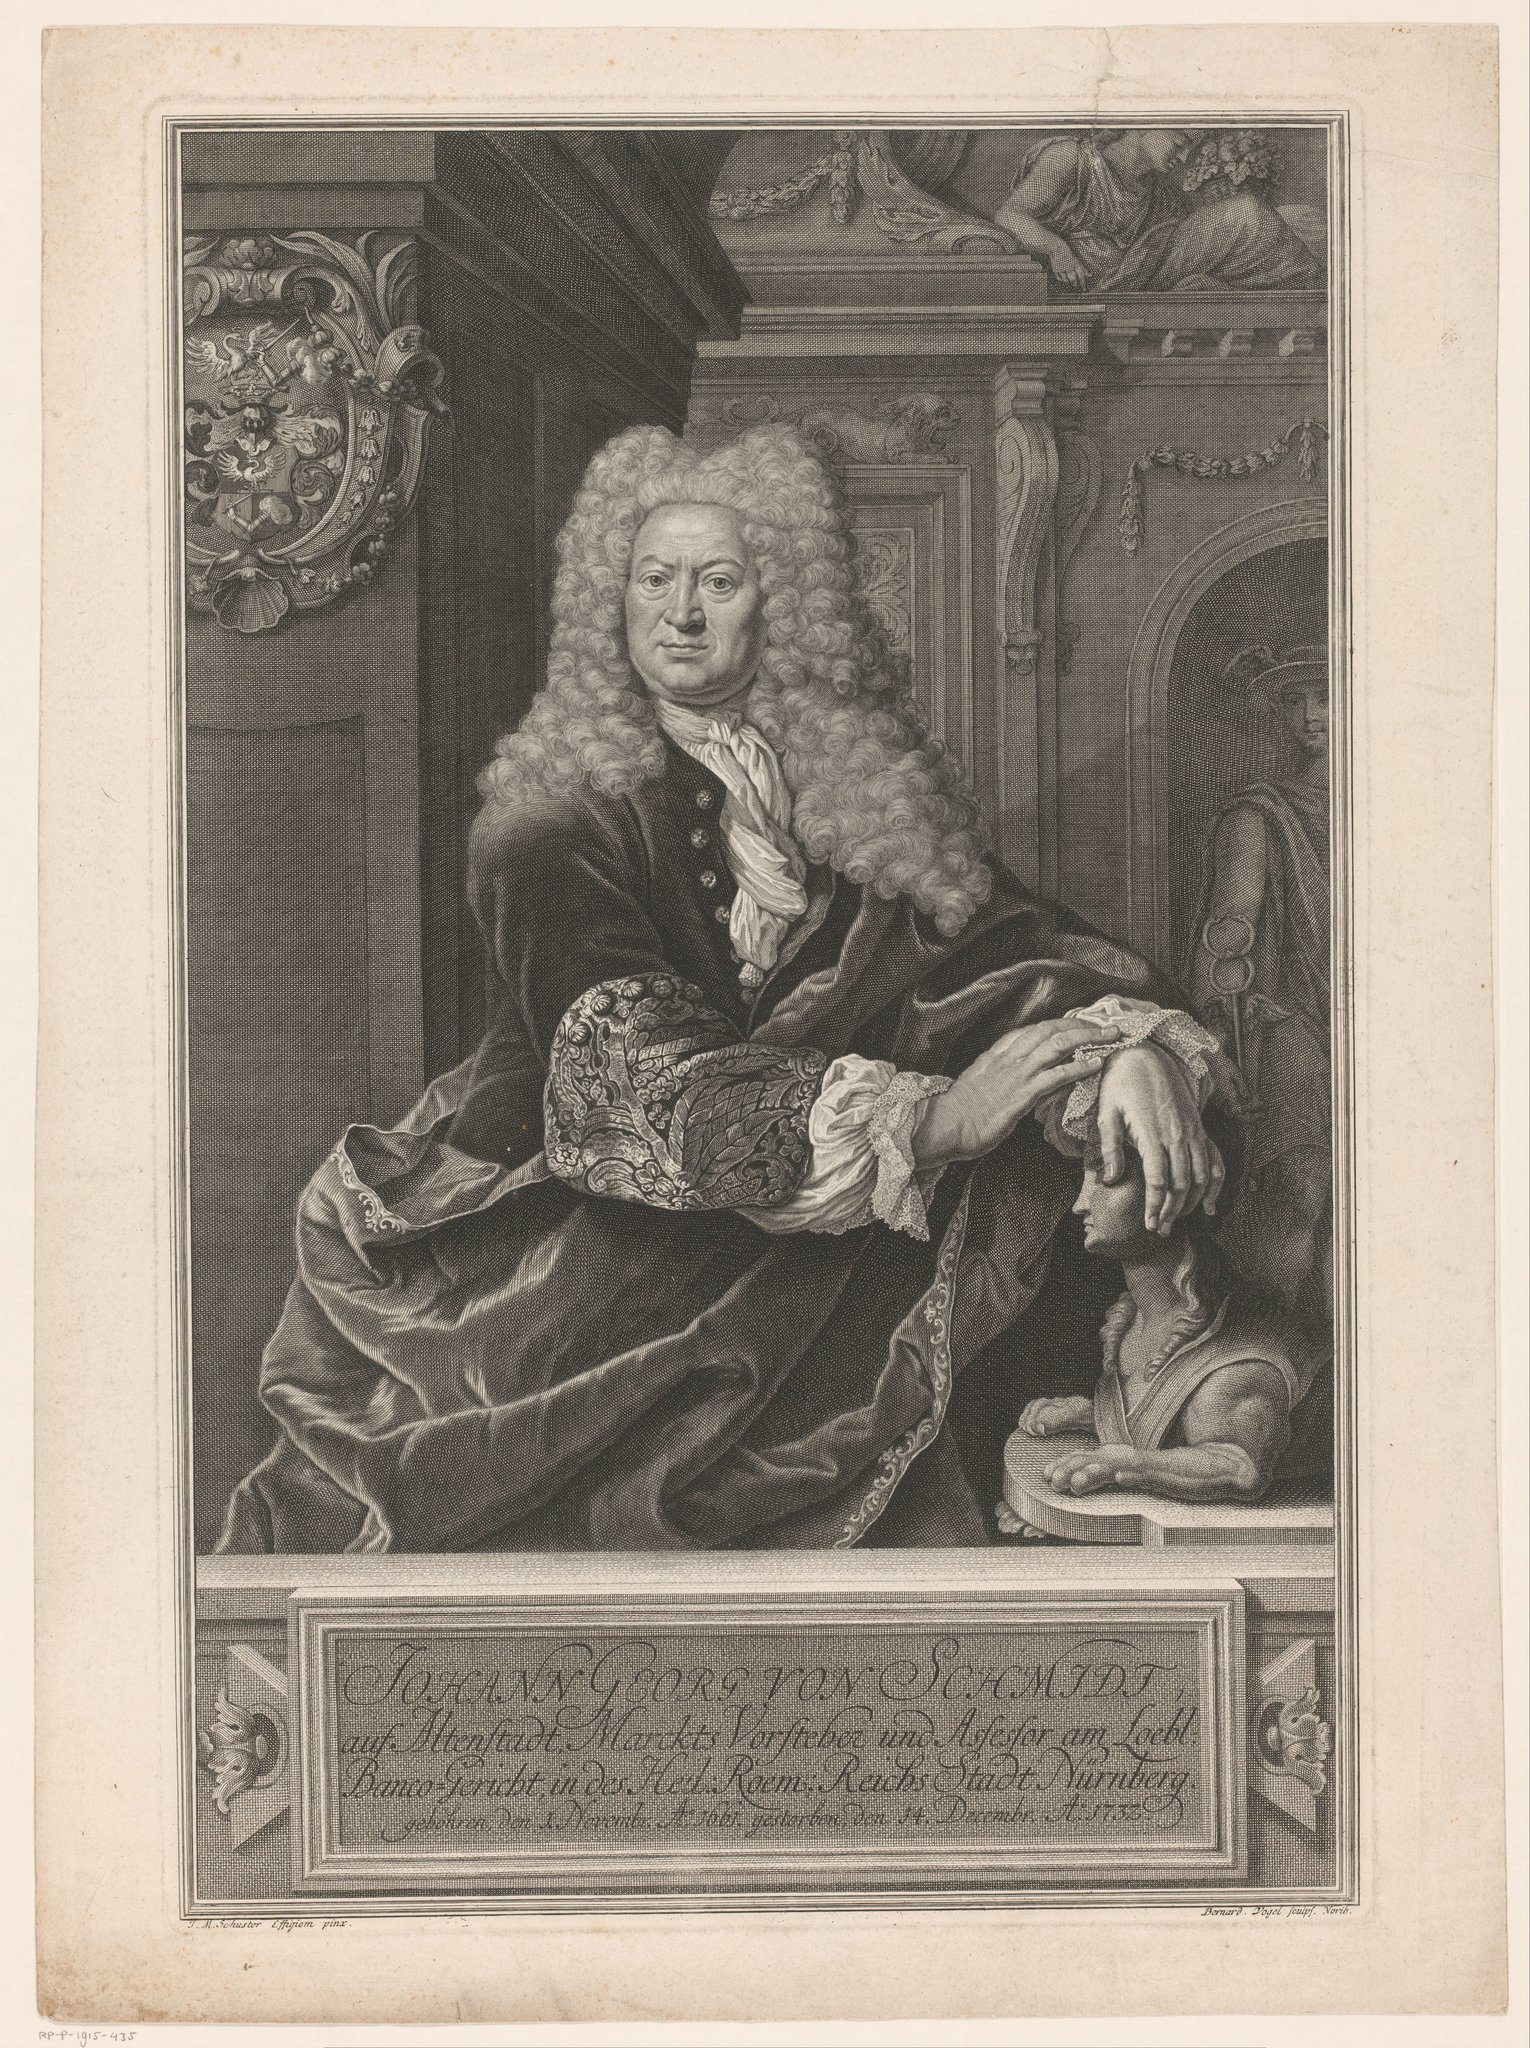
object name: print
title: Portret van Johann Georg von Schmidt auf Altenstadt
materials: paper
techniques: engraving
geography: nuremberg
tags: sphinx (lion/woman); 'sfinge' (ripa), (story of) mercury (hermes), historical persons, piece of sculpture, reproduction of a piece of sculpture, armorial bearing, heraldry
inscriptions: collector's mark: Lugt 2228